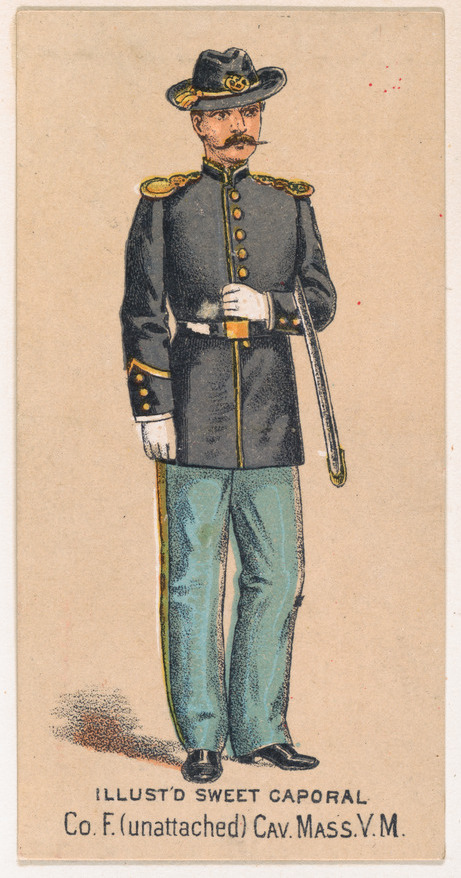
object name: print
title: Co. F. (unattached), Cavalry, Massachusetts, V.M., from the Military Series (N224) issued by Kinney Tobacco Company to promote Sweet Caporal Cigarettes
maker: kinney brothers tobacco company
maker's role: publisher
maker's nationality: american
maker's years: 1869-2011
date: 1888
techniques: color lithograph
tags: military,men